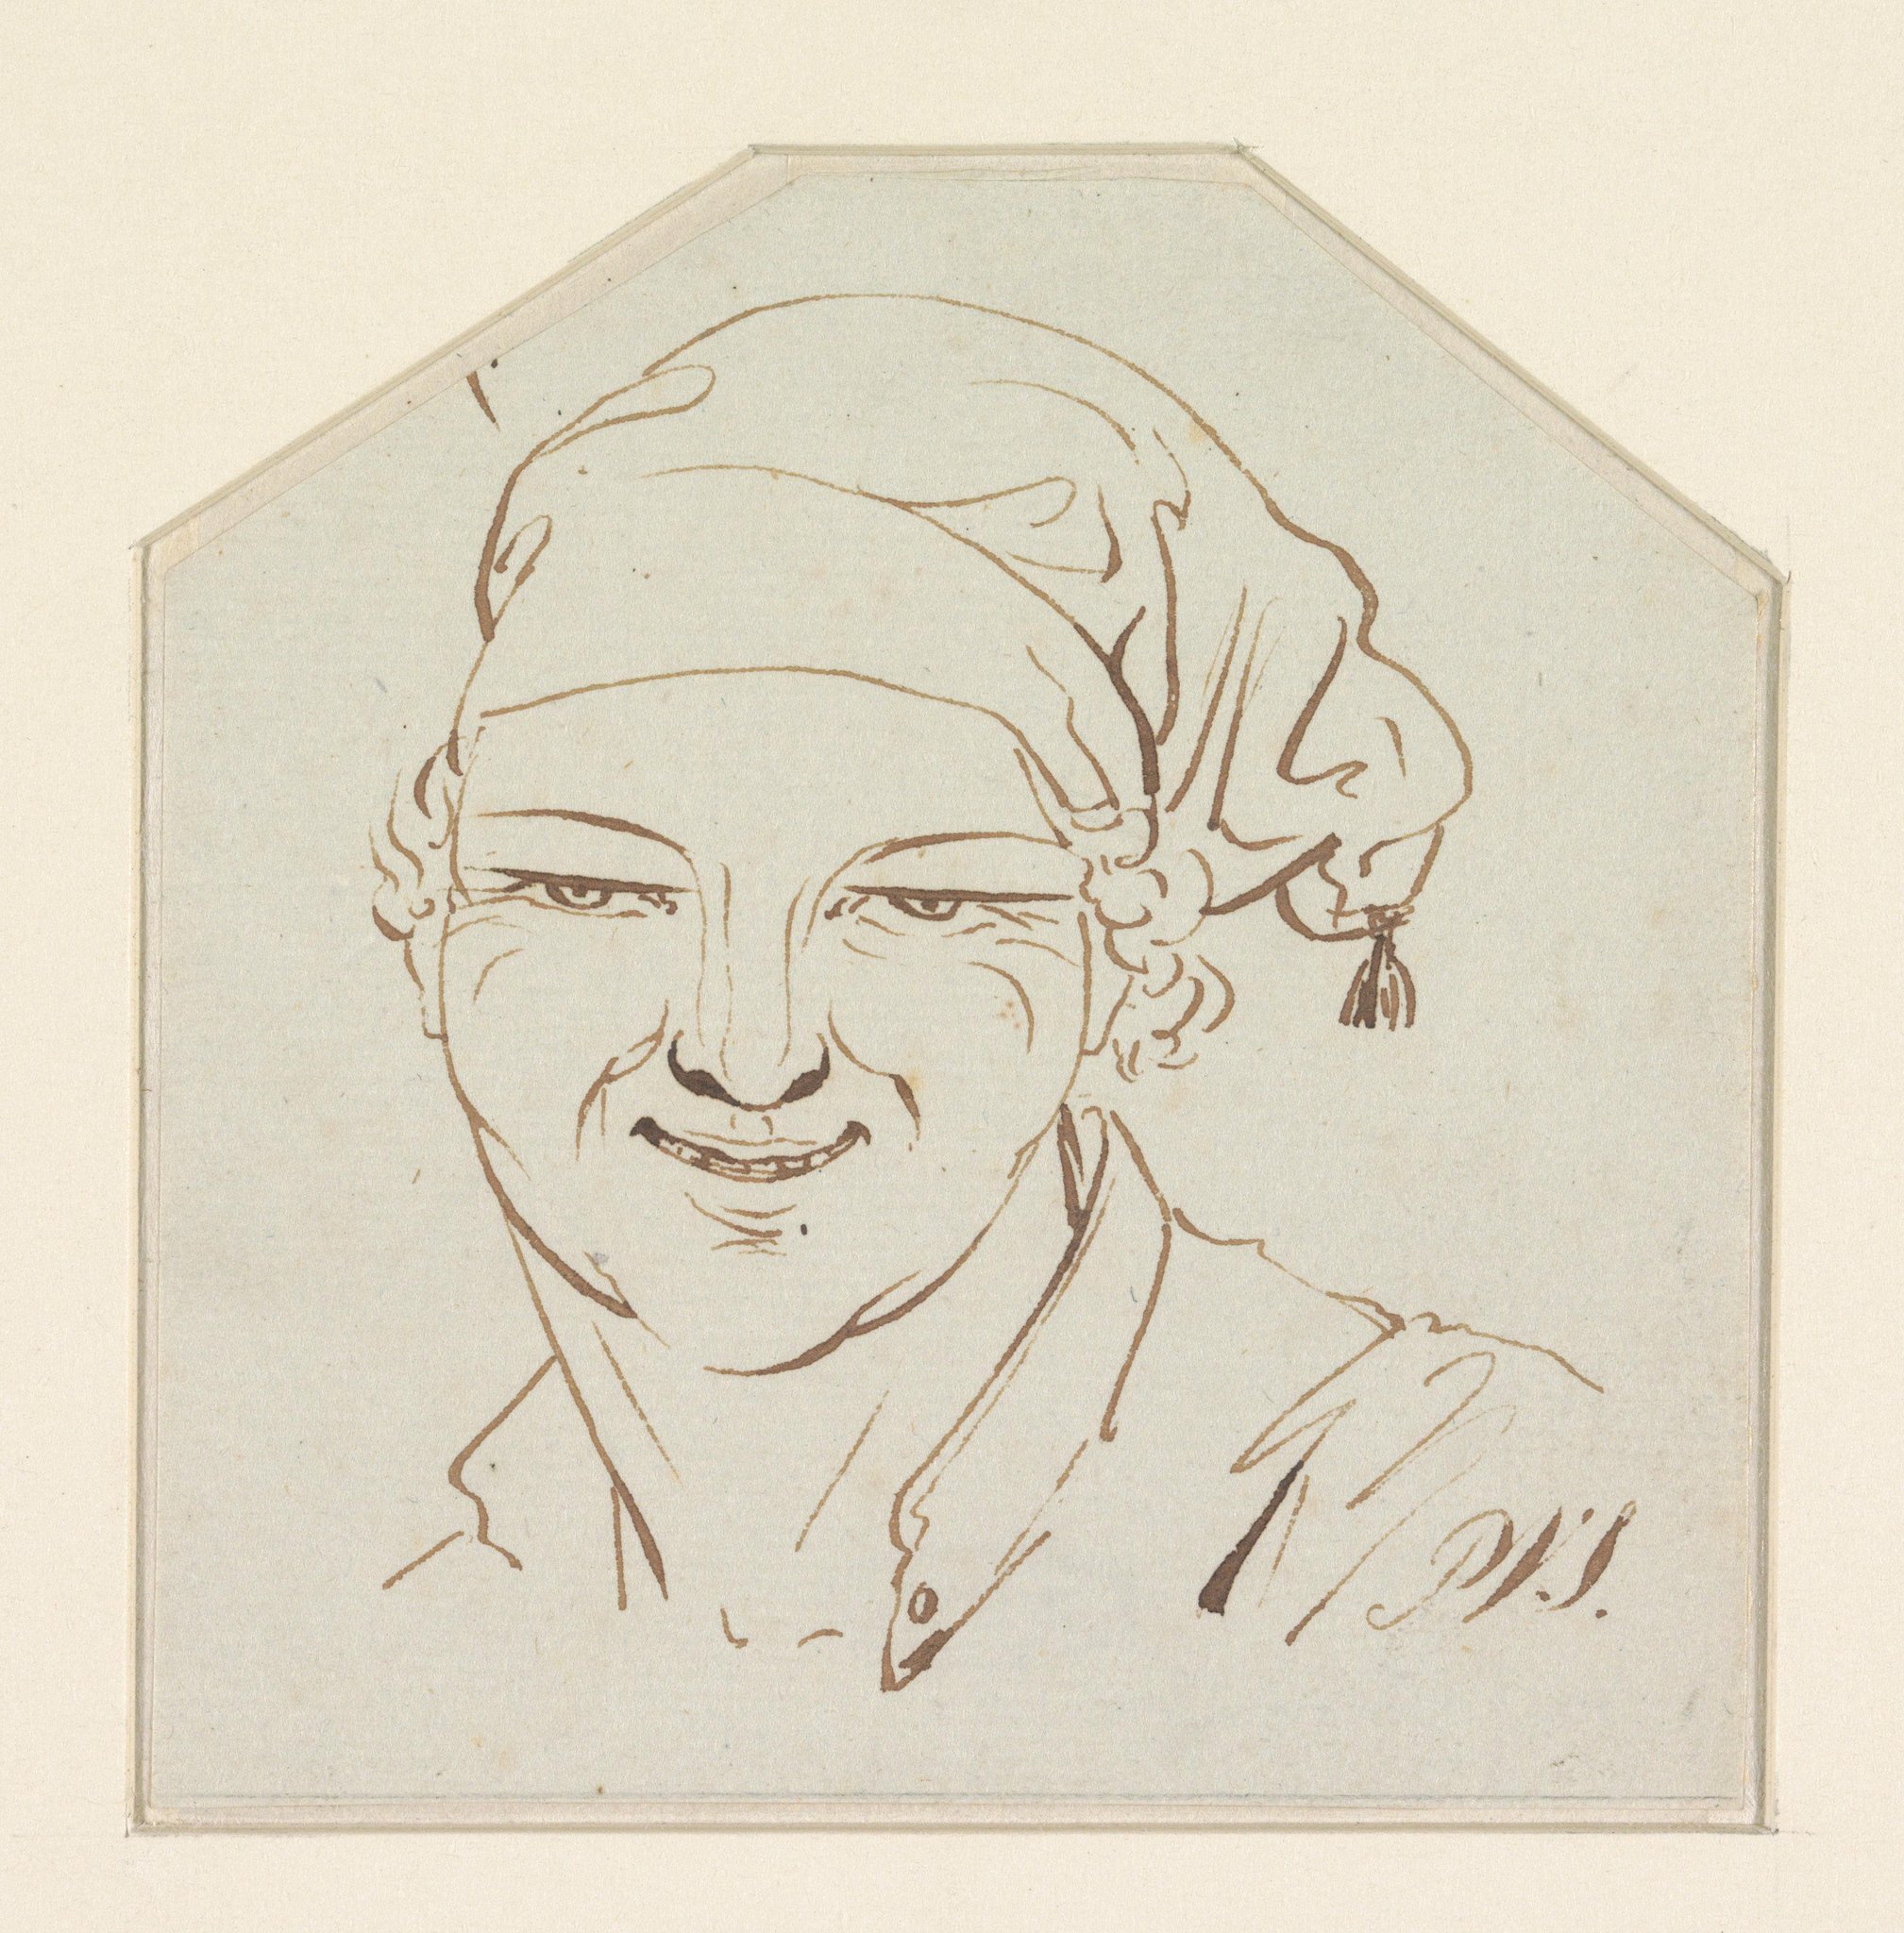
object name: drawing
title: Manshoofd met hangende muts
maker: petrus van schendel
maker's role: draughtsman, painter, print maker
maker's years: 1806-1870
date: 1816-1870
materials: ink, paper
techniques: pen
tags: head (human)